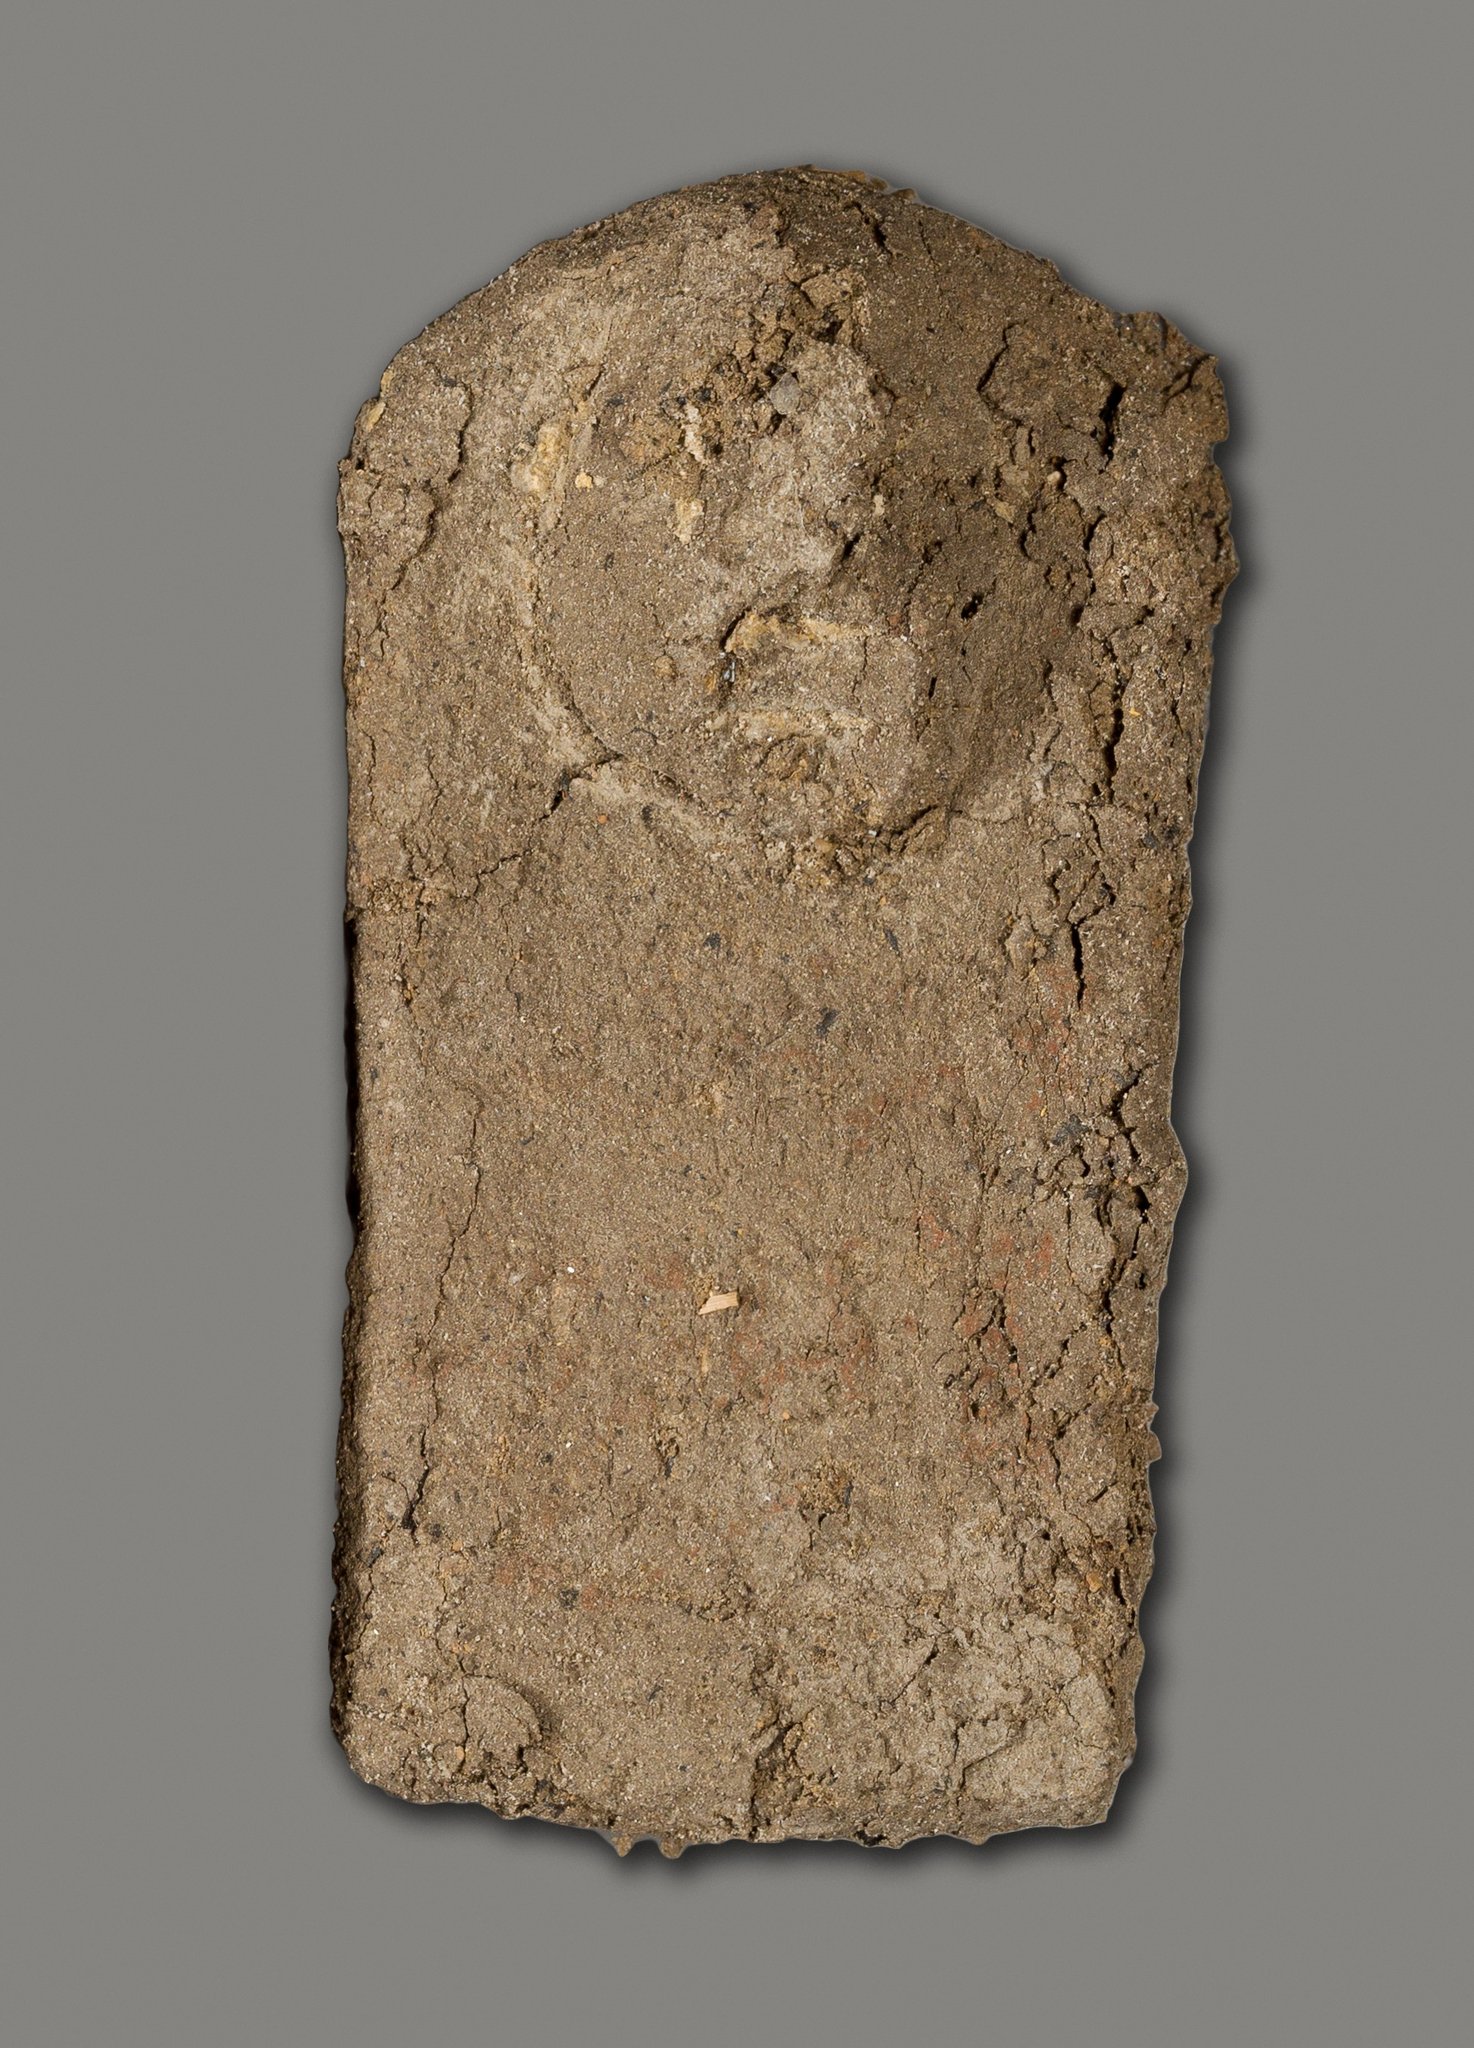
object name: figure, magical, execration, tablet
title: Magical Figure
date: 1802-1550 BCE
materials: clay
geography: egypt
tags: faces